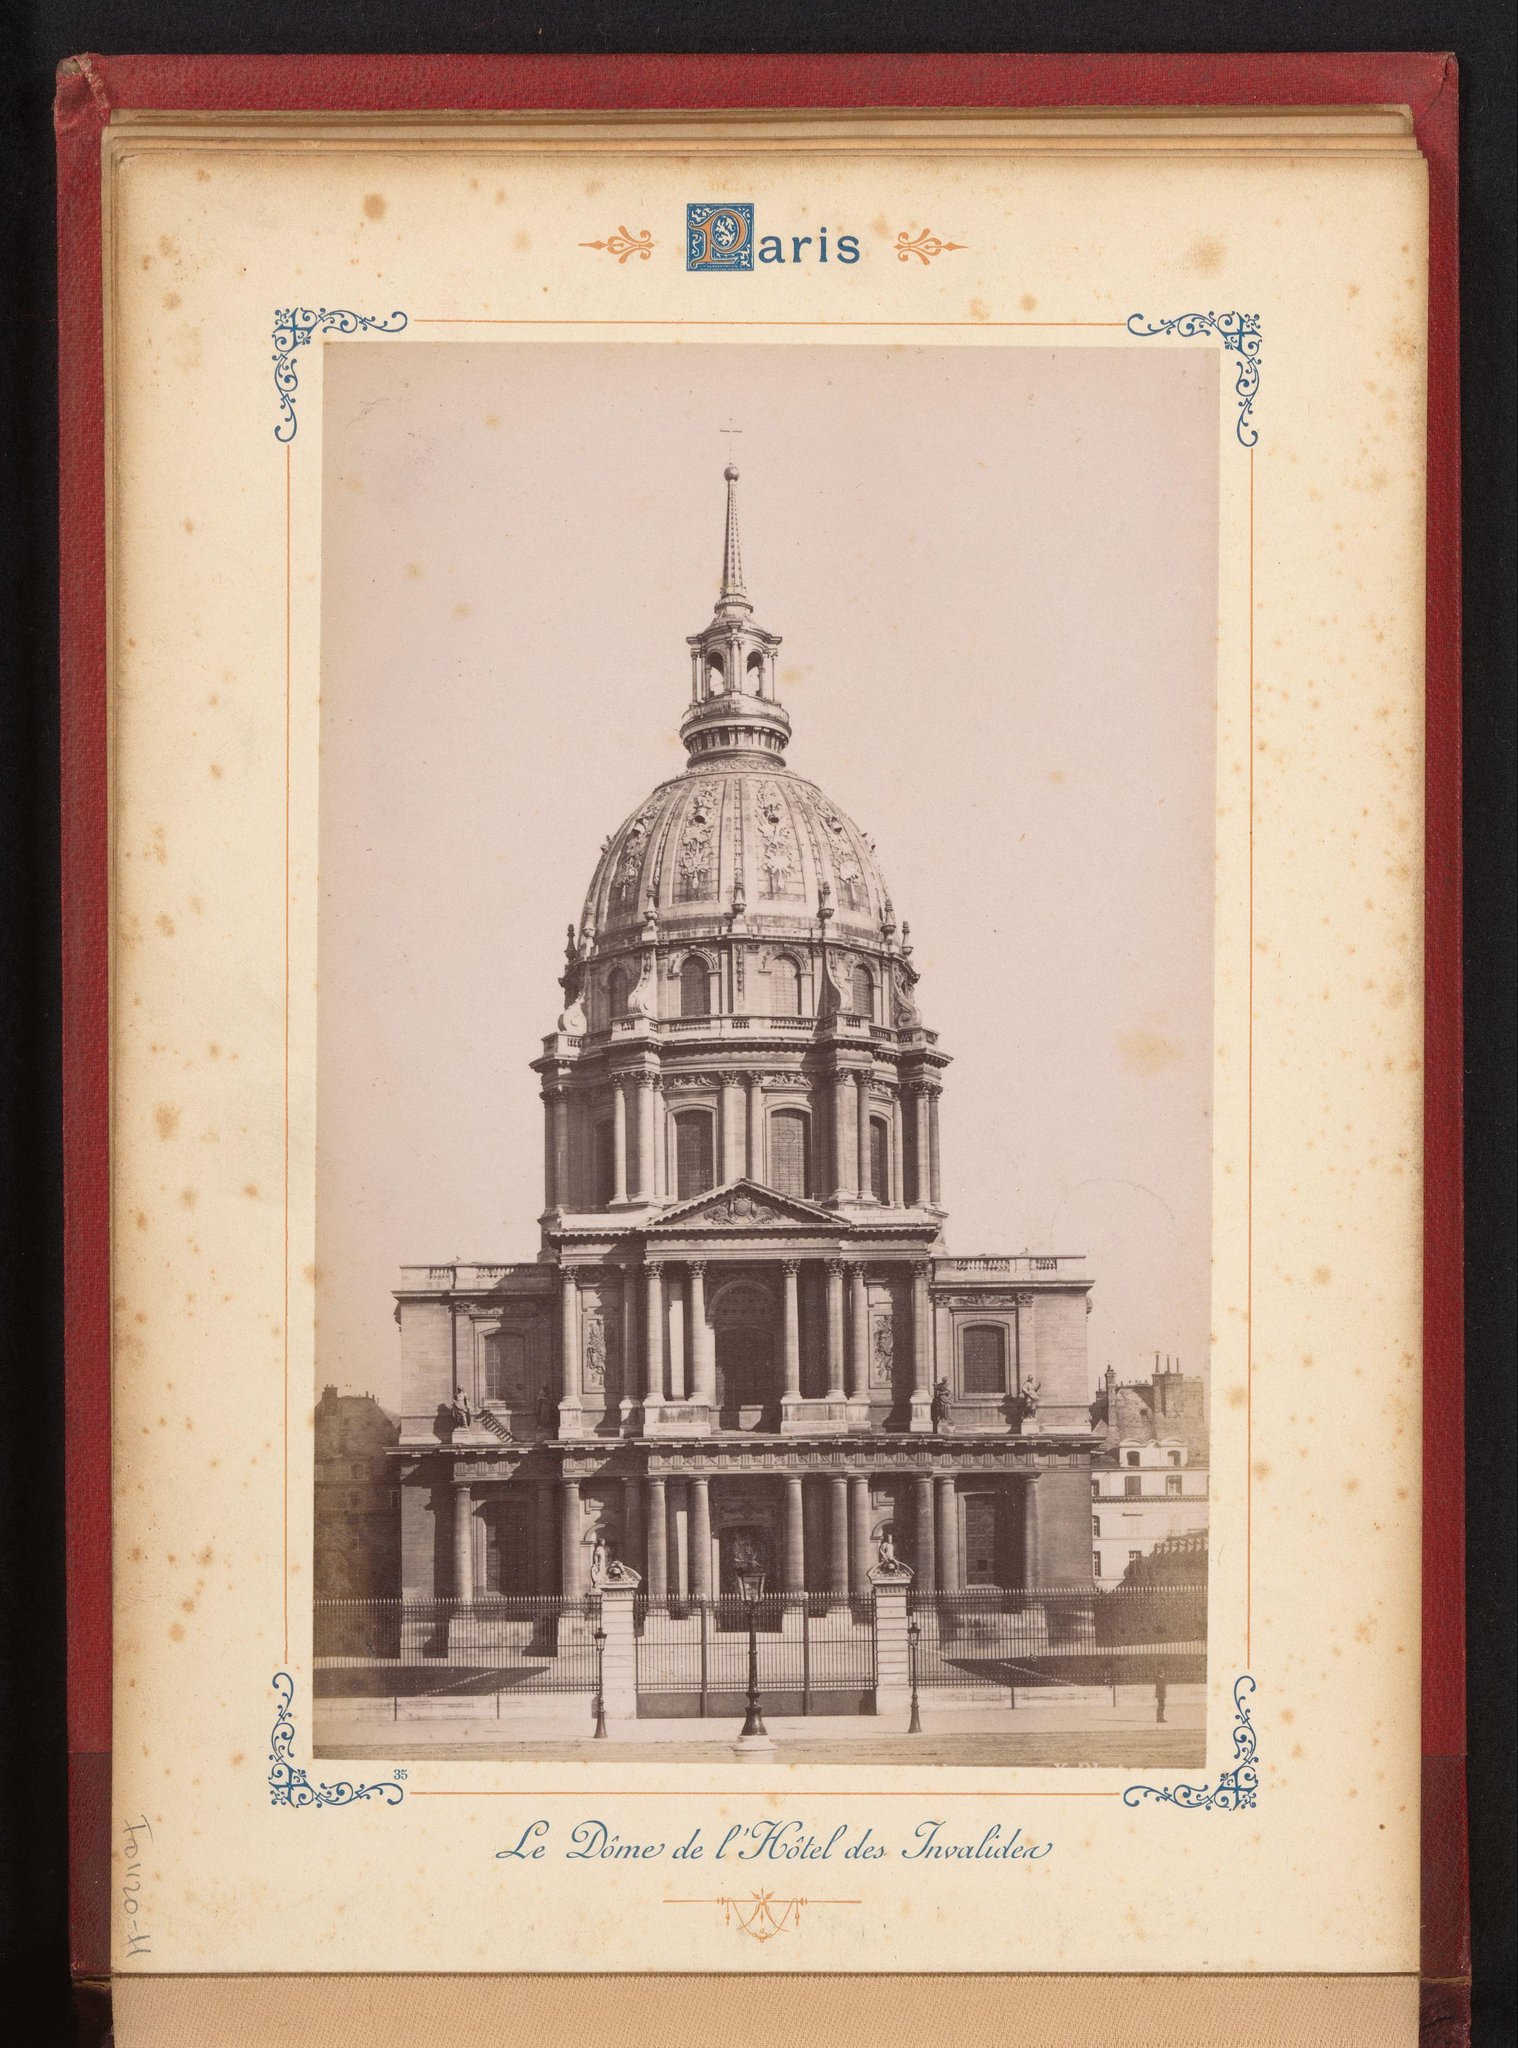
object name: album leaf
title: Paris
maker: Anonymous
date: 1885-1900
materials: cardboard, photographic support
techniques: albumen print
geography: paris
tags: hospital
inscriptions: number: ‘35’